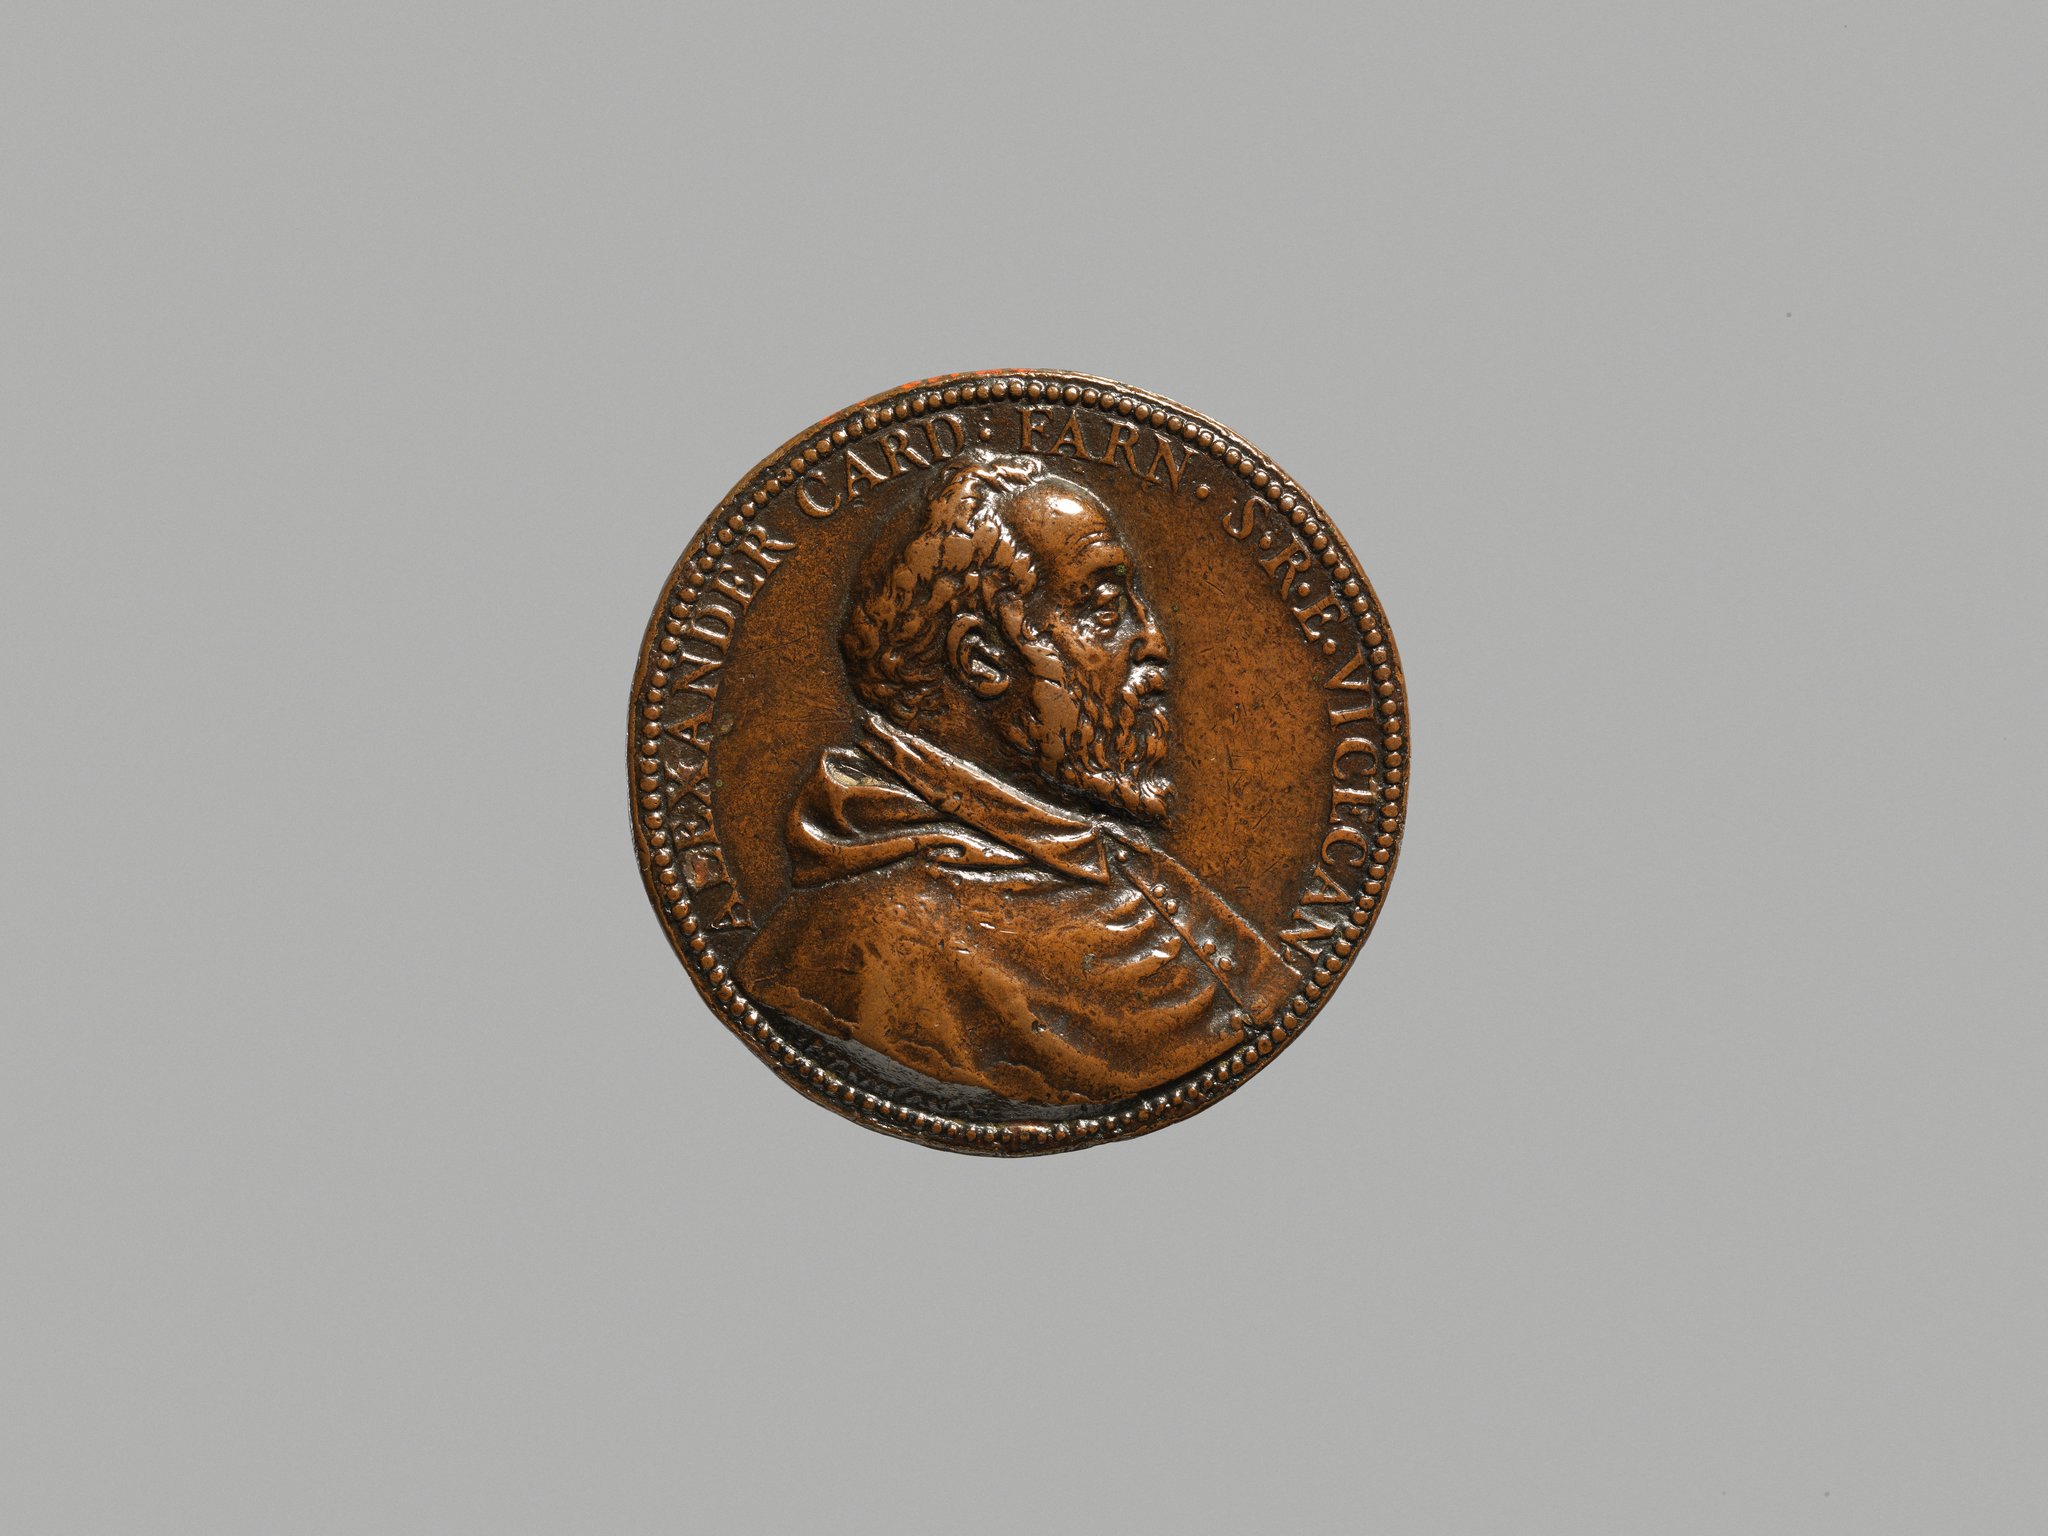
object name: medal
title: Cardinal Alessandro Farnese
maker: giovanni v. melon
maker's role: artist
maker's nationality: italian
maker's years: 1565-1590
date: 1575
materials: bronze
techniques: casting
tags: buildings,men,profiles